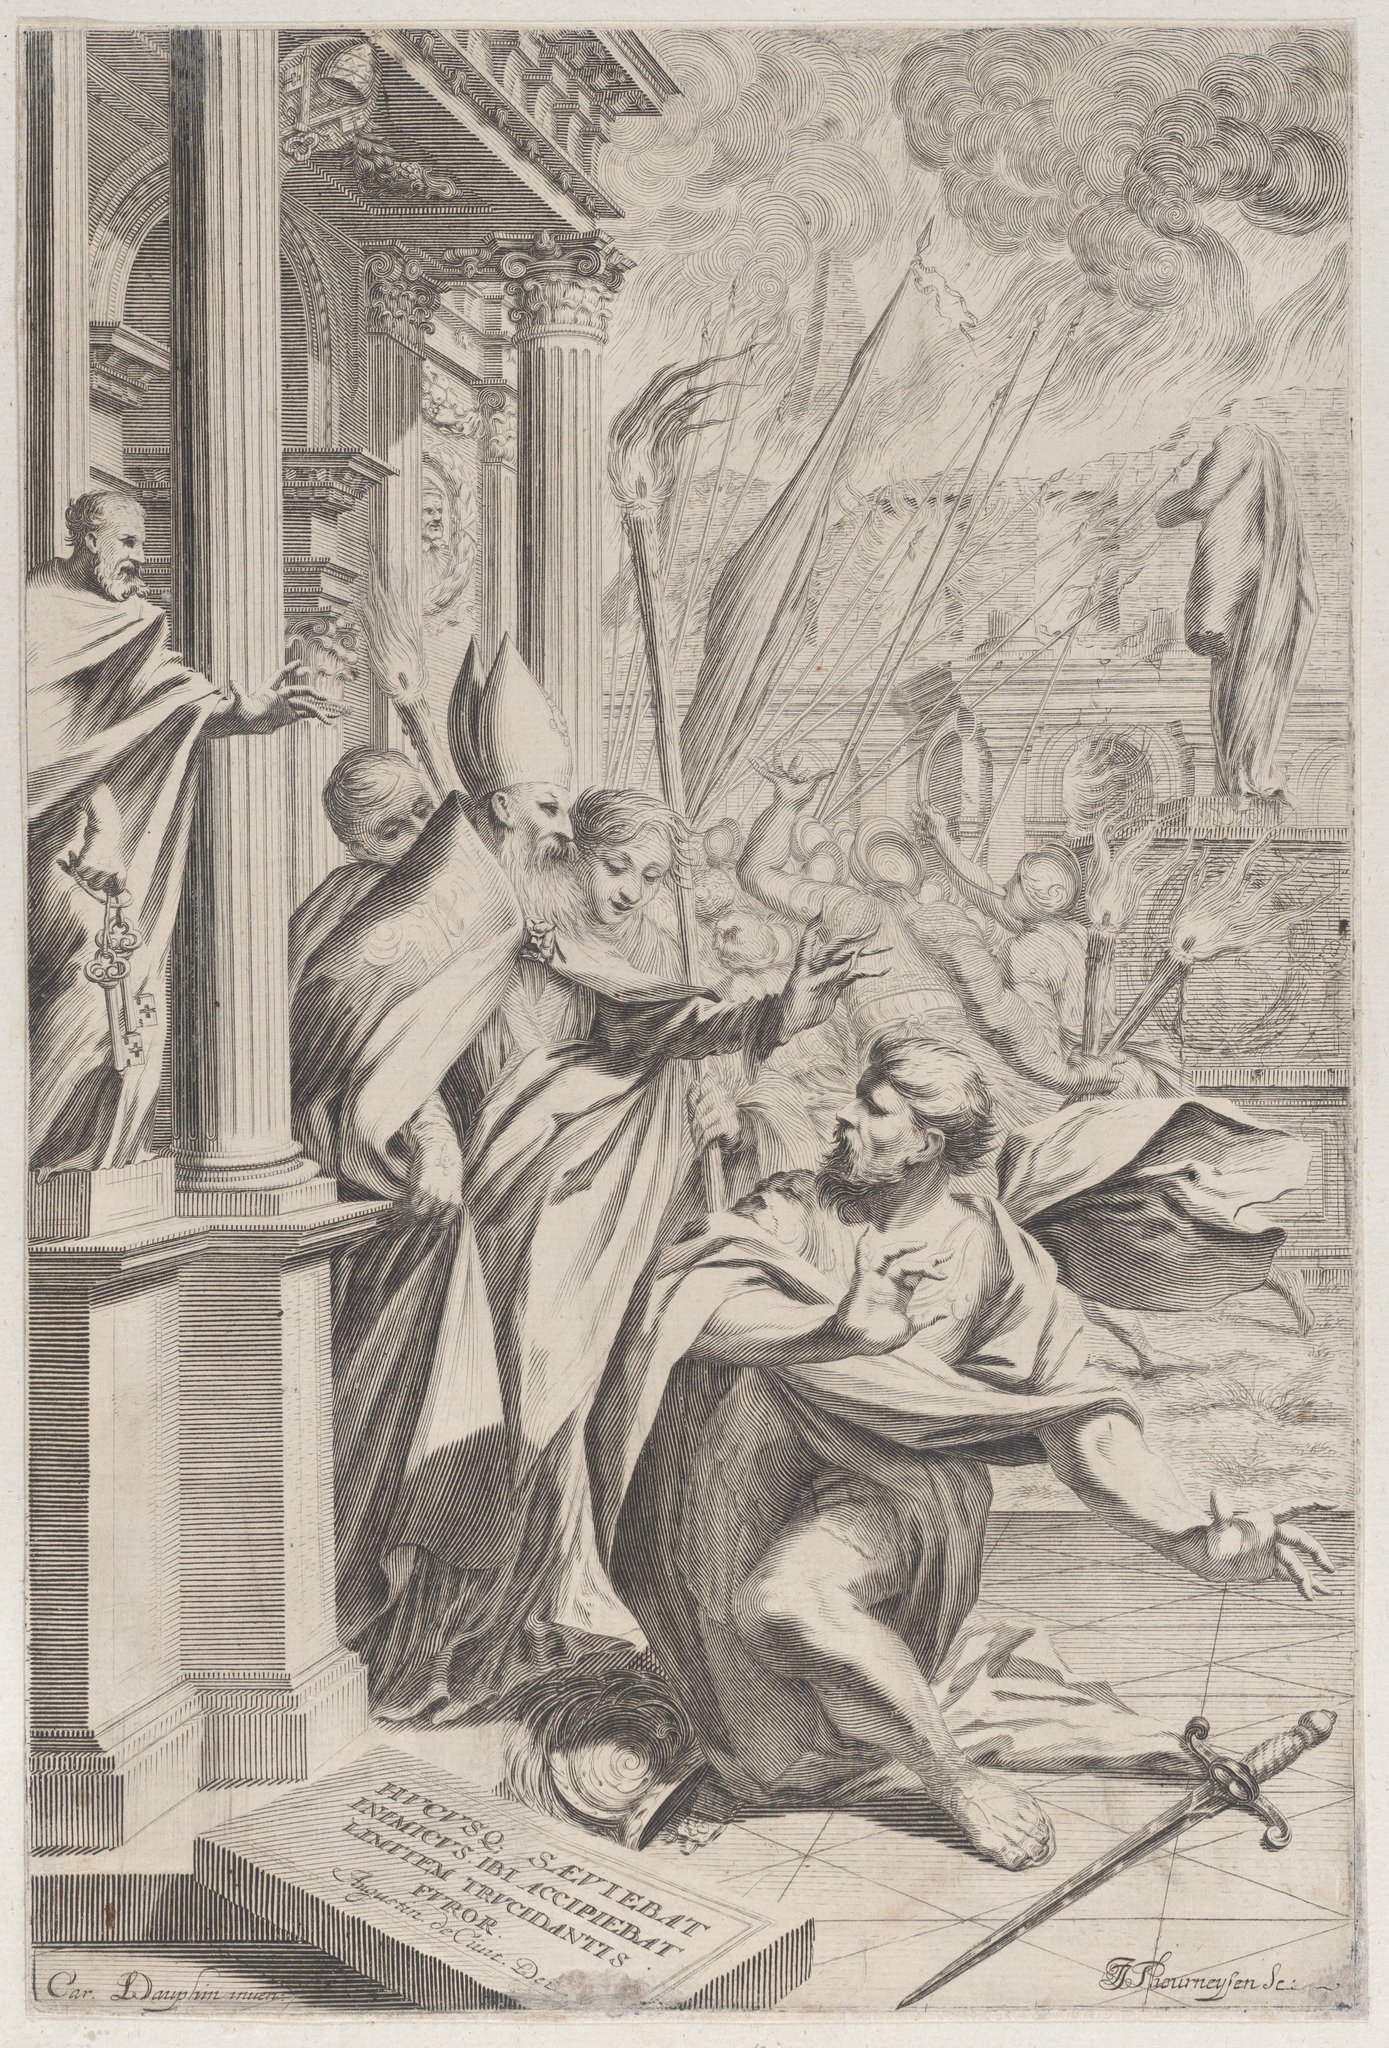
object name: print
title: Saint Ambrose repelling Emperor Theodosius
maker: johann jakob thurneysen, the elder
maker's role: artist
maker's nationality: swiss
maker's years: 1636-1711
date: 1652-1711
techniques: engraving